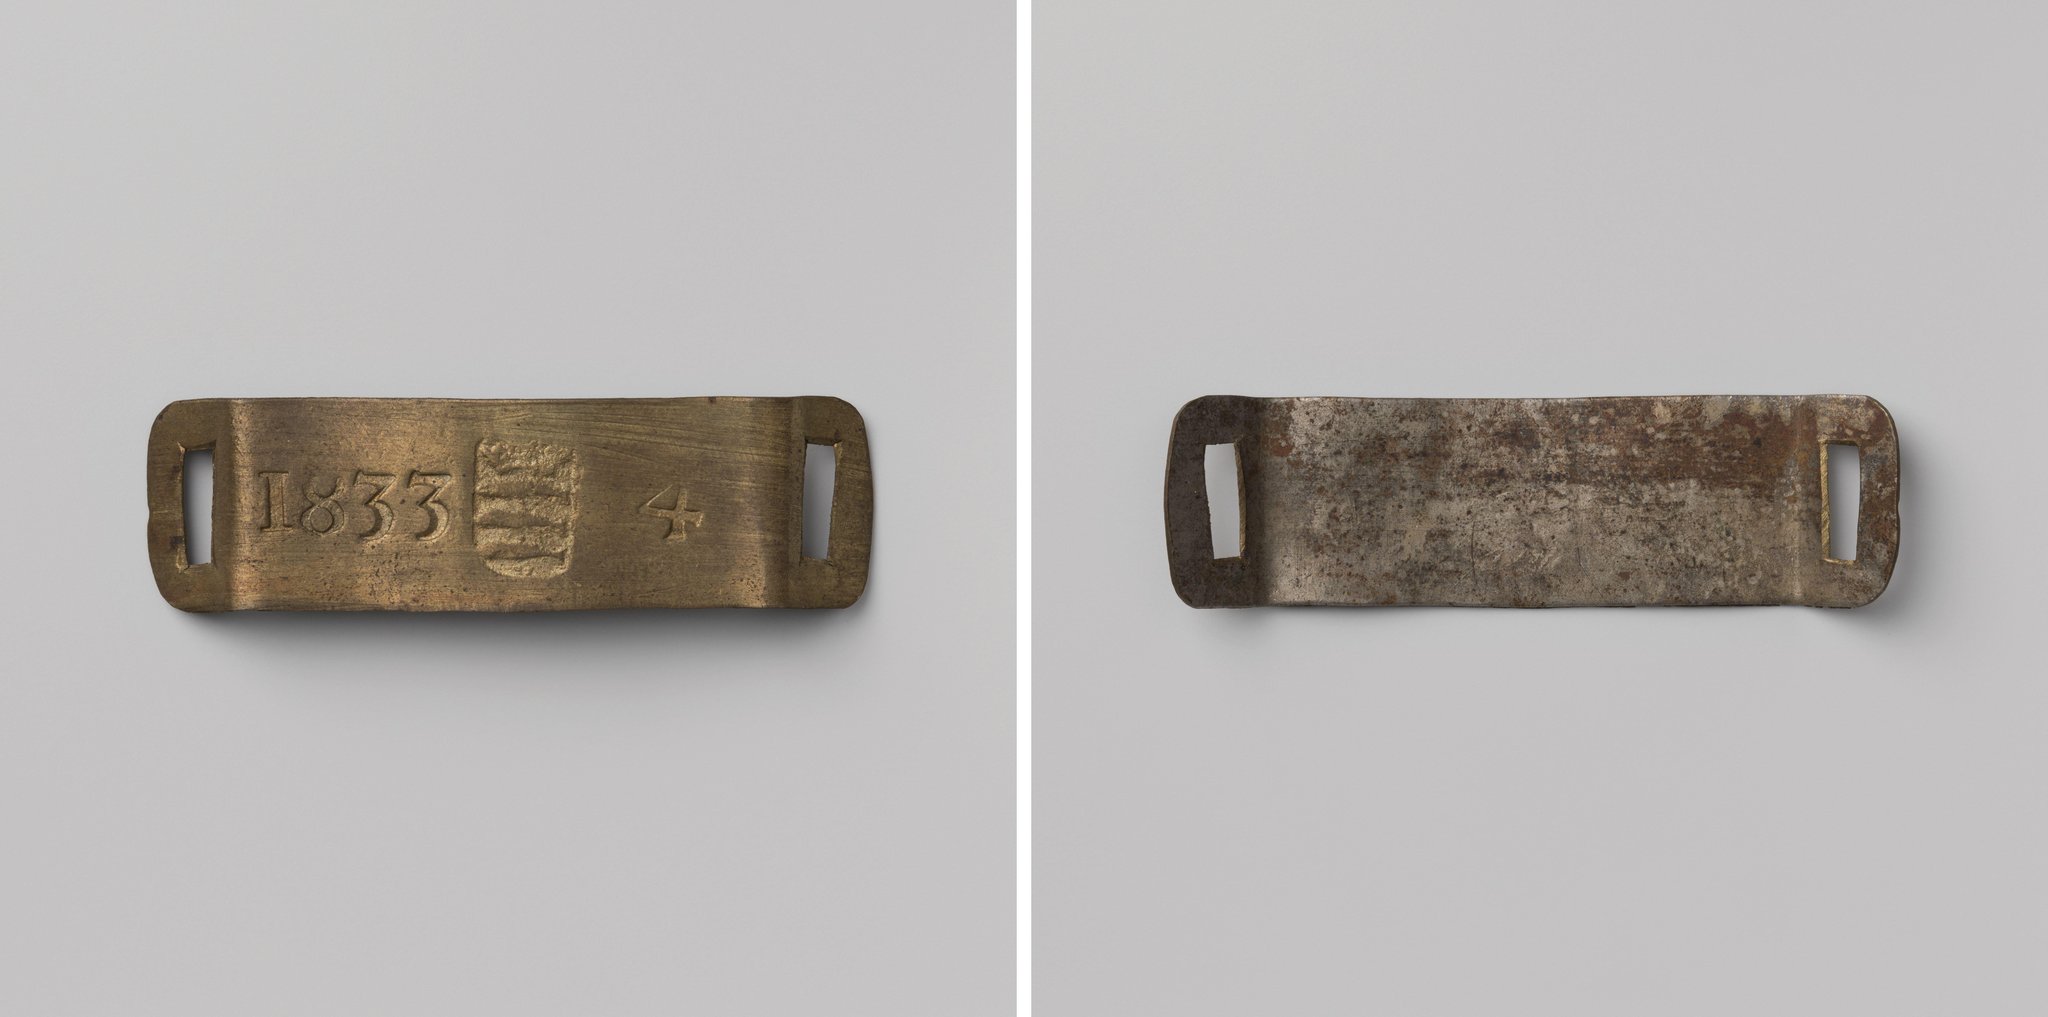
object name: tax token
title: Stad Enkhuizen, loodje met no. 4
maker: Anonymous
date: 1833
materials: brass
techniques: striking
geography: enkhuizen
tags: enkhuizen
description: eenzijdig, staafvormig loodje met omgebogen uiteinden met daarin rechthoekige uitsparing. Voorzijde: wapenschild met ter linkerzijde jaartal, ter rechterzijde cijfer 4. Keerzijde: blanco